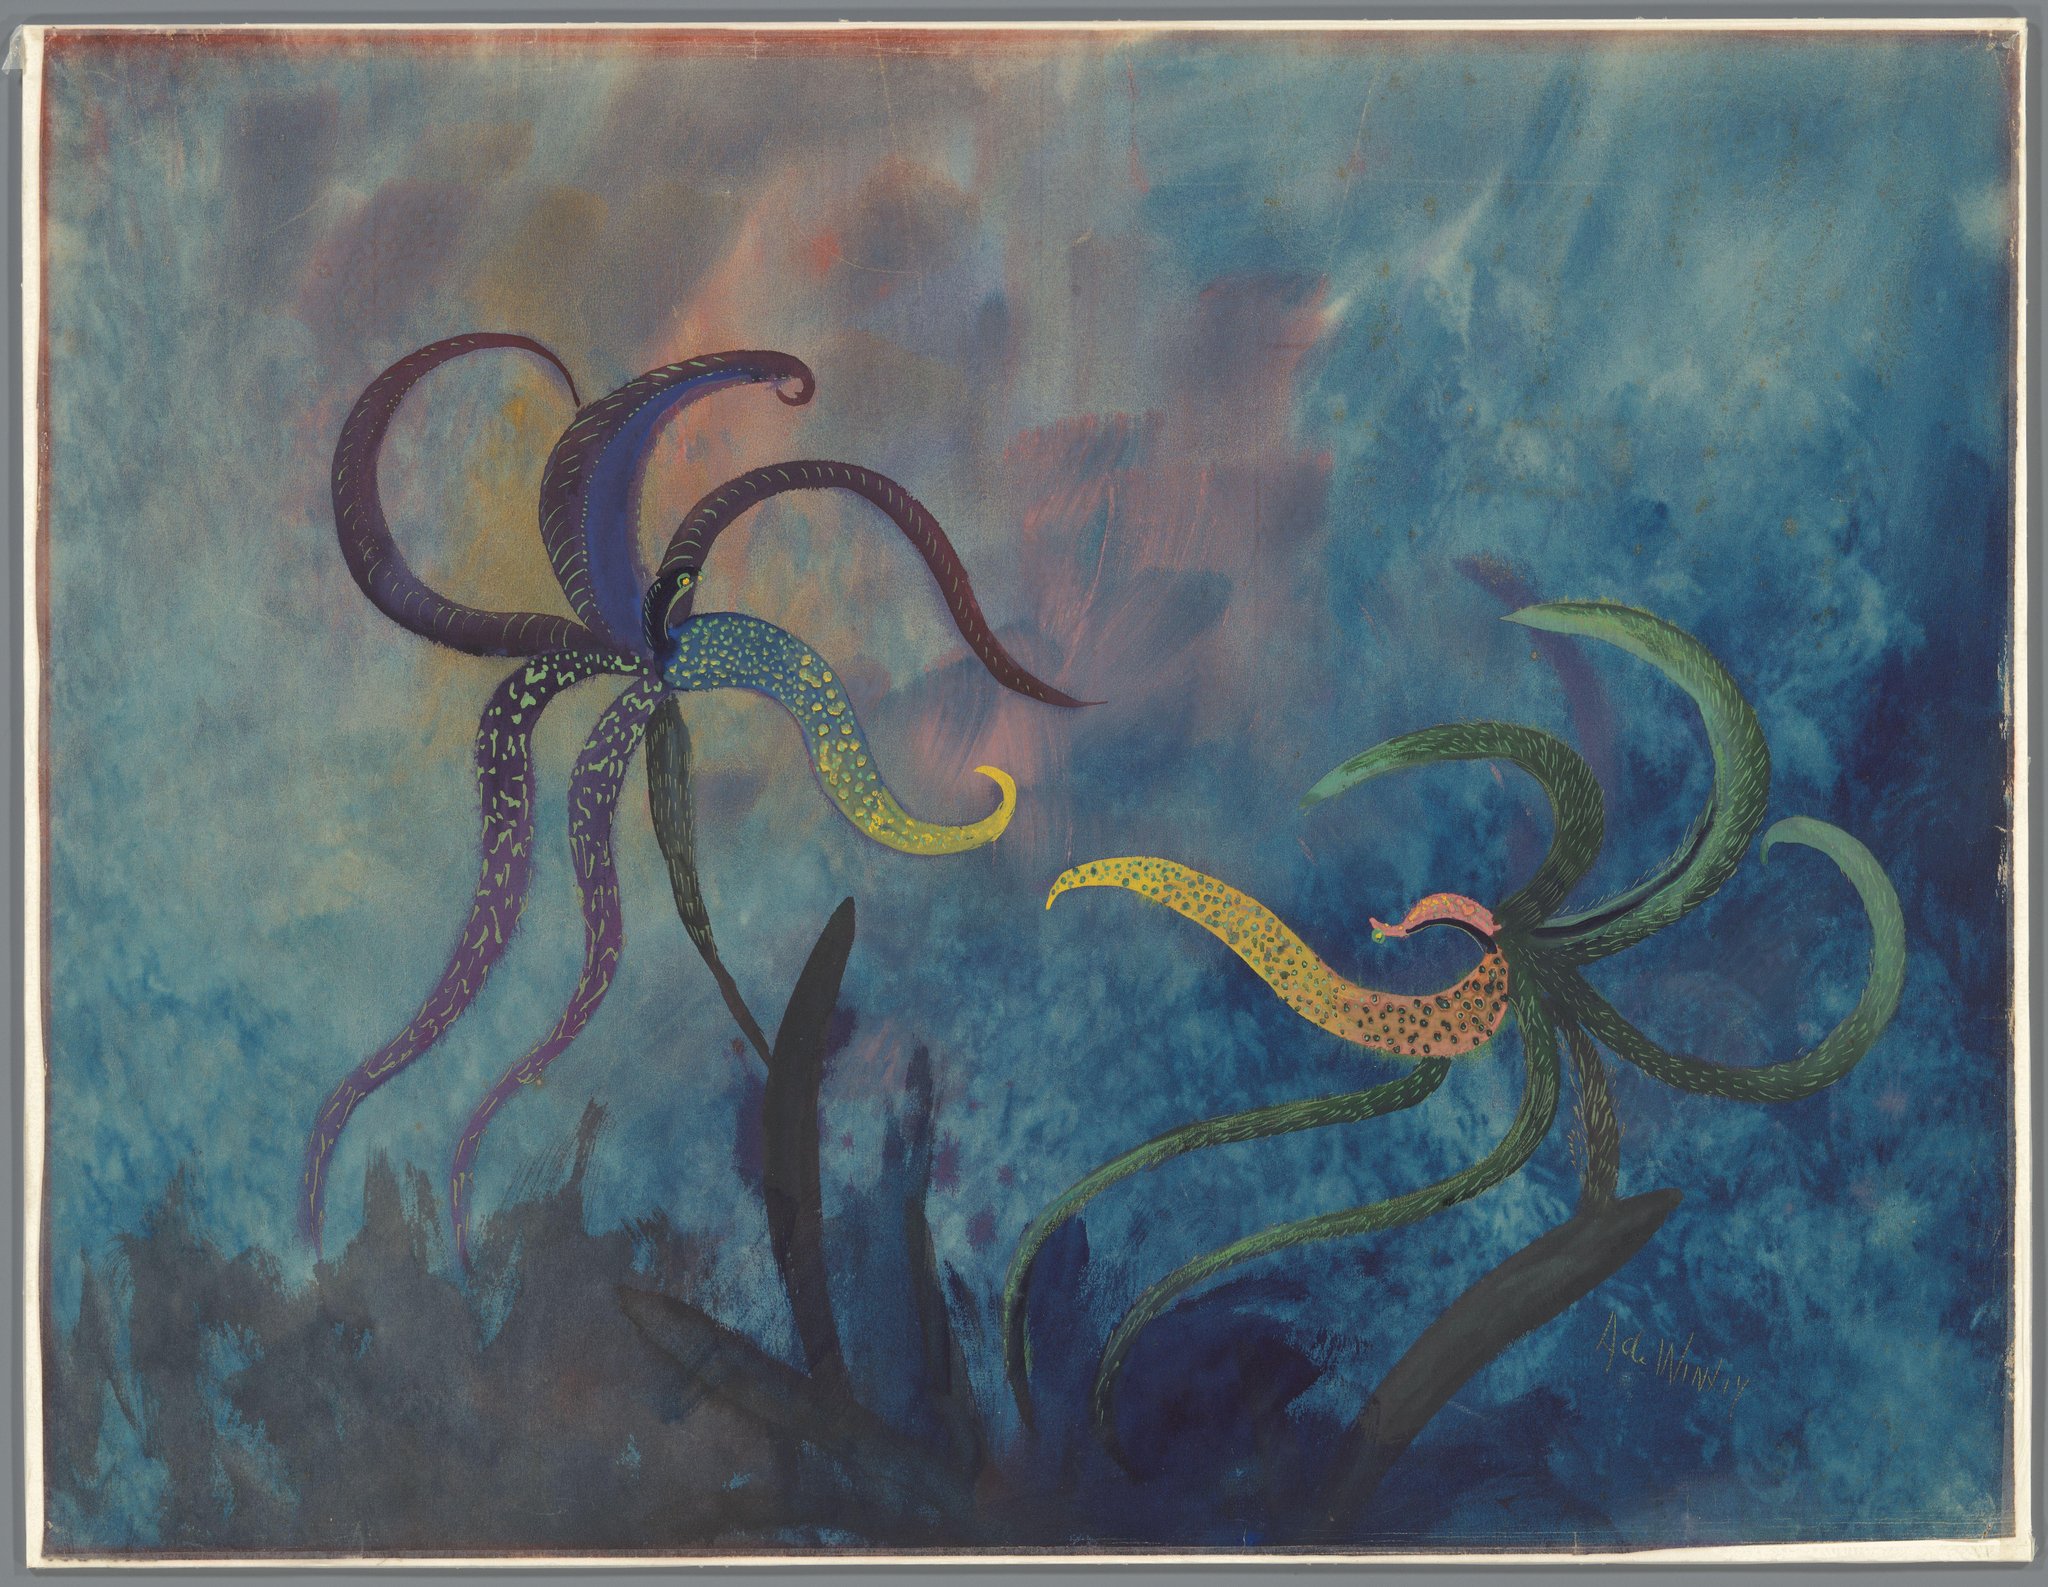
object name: drawing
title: Fighting Orchids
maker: janus de winter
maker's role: print maker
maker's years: 1882-1951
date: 1917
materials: gouache, paper, watercolor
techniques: brush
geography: netherlands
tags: flowers: orchid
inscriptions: signature and date: ‘A de Wint17’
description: Janus de Winter raised a furore around 1916 with depictions of his own feelings – ‘sensations’ – as abstractions. He transformed moods into visionary images for which recognisable motifs were stylised and adapted. His art impressed Theo van Doesburg (1883-1931), founder of De Stijl, who briefly attempted to make abstract art in the manner of De Winter.